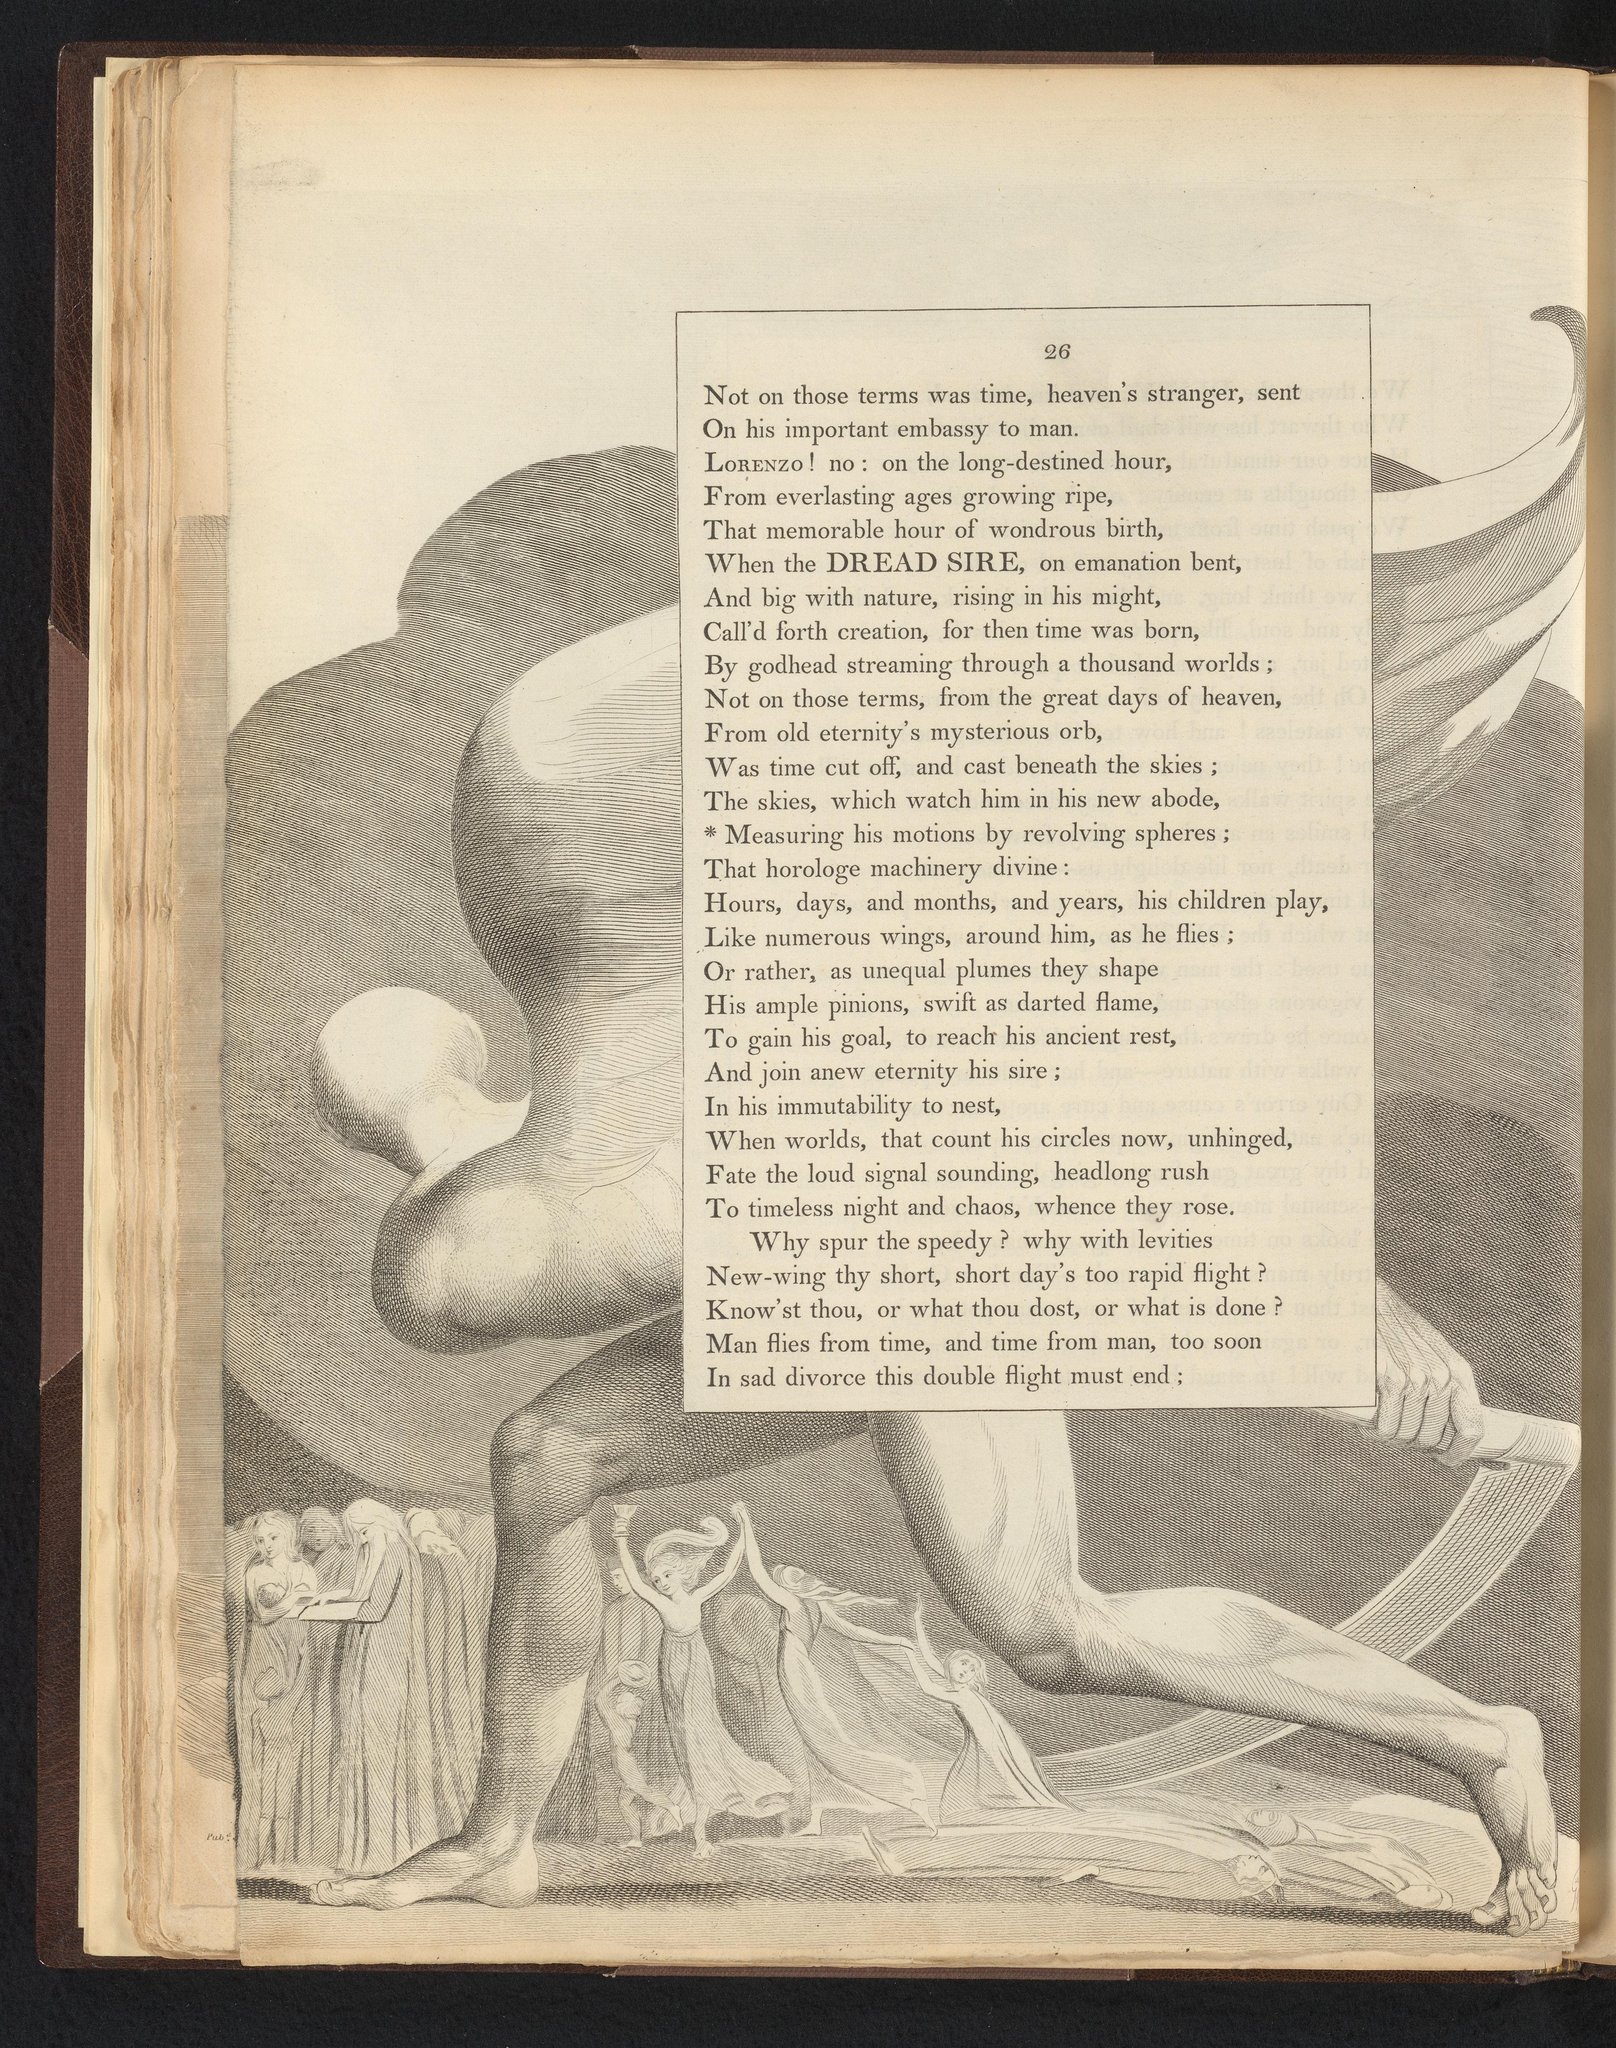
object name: print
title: Dansende vrouwen en kinderen worden gemaaid door Vadertje Tijd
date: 1796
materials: paper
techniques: engraving, letterpress printing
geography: london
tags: mother and child(ren), woman and child(ren) (family group), father time, man with wings and scythe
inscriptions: : ‘Not on those terms was time, heaven's stranger, sent (...)’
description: Prent maakt deel uit van een boek, bladzijde 26. Tekst in het Engels op recto en verso.